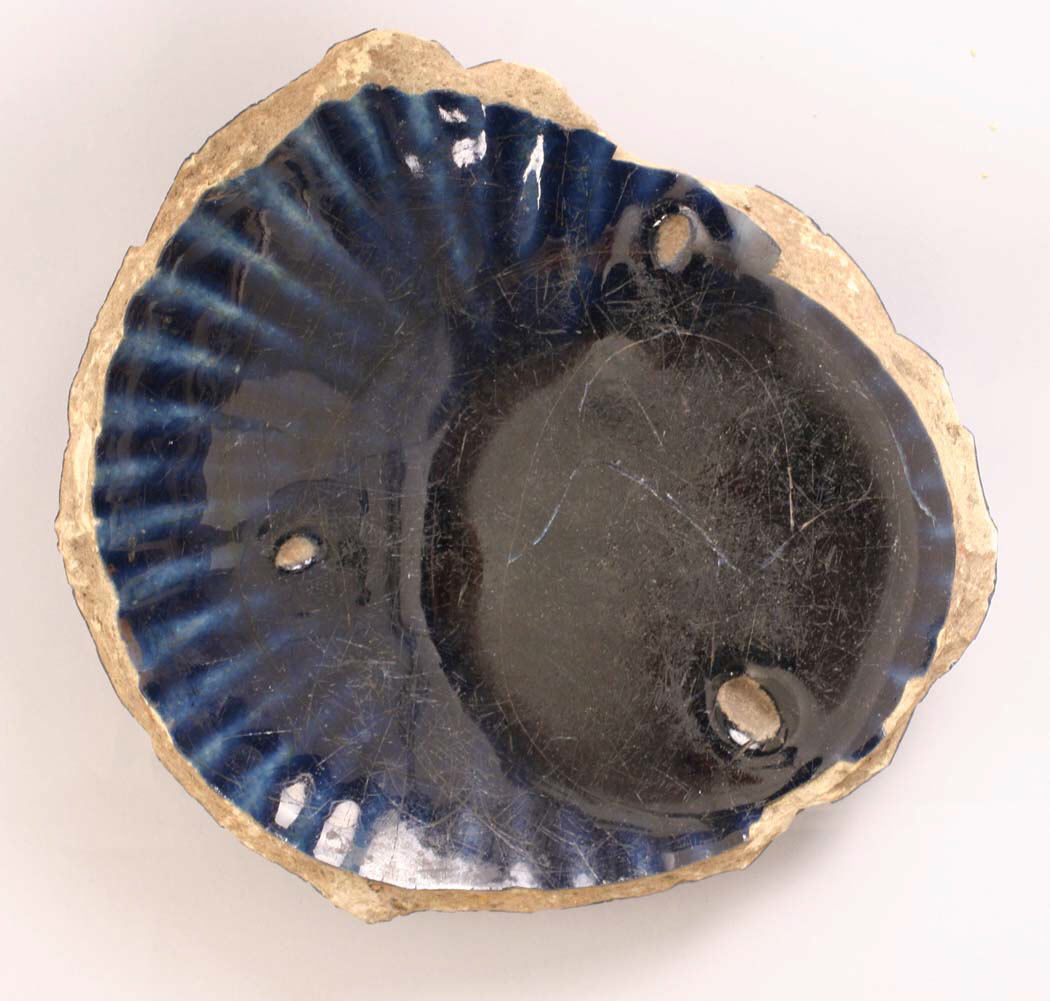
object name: fragment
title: Fragment of a Bowl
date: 1301-1400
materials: glaze, stonepaste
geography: syria